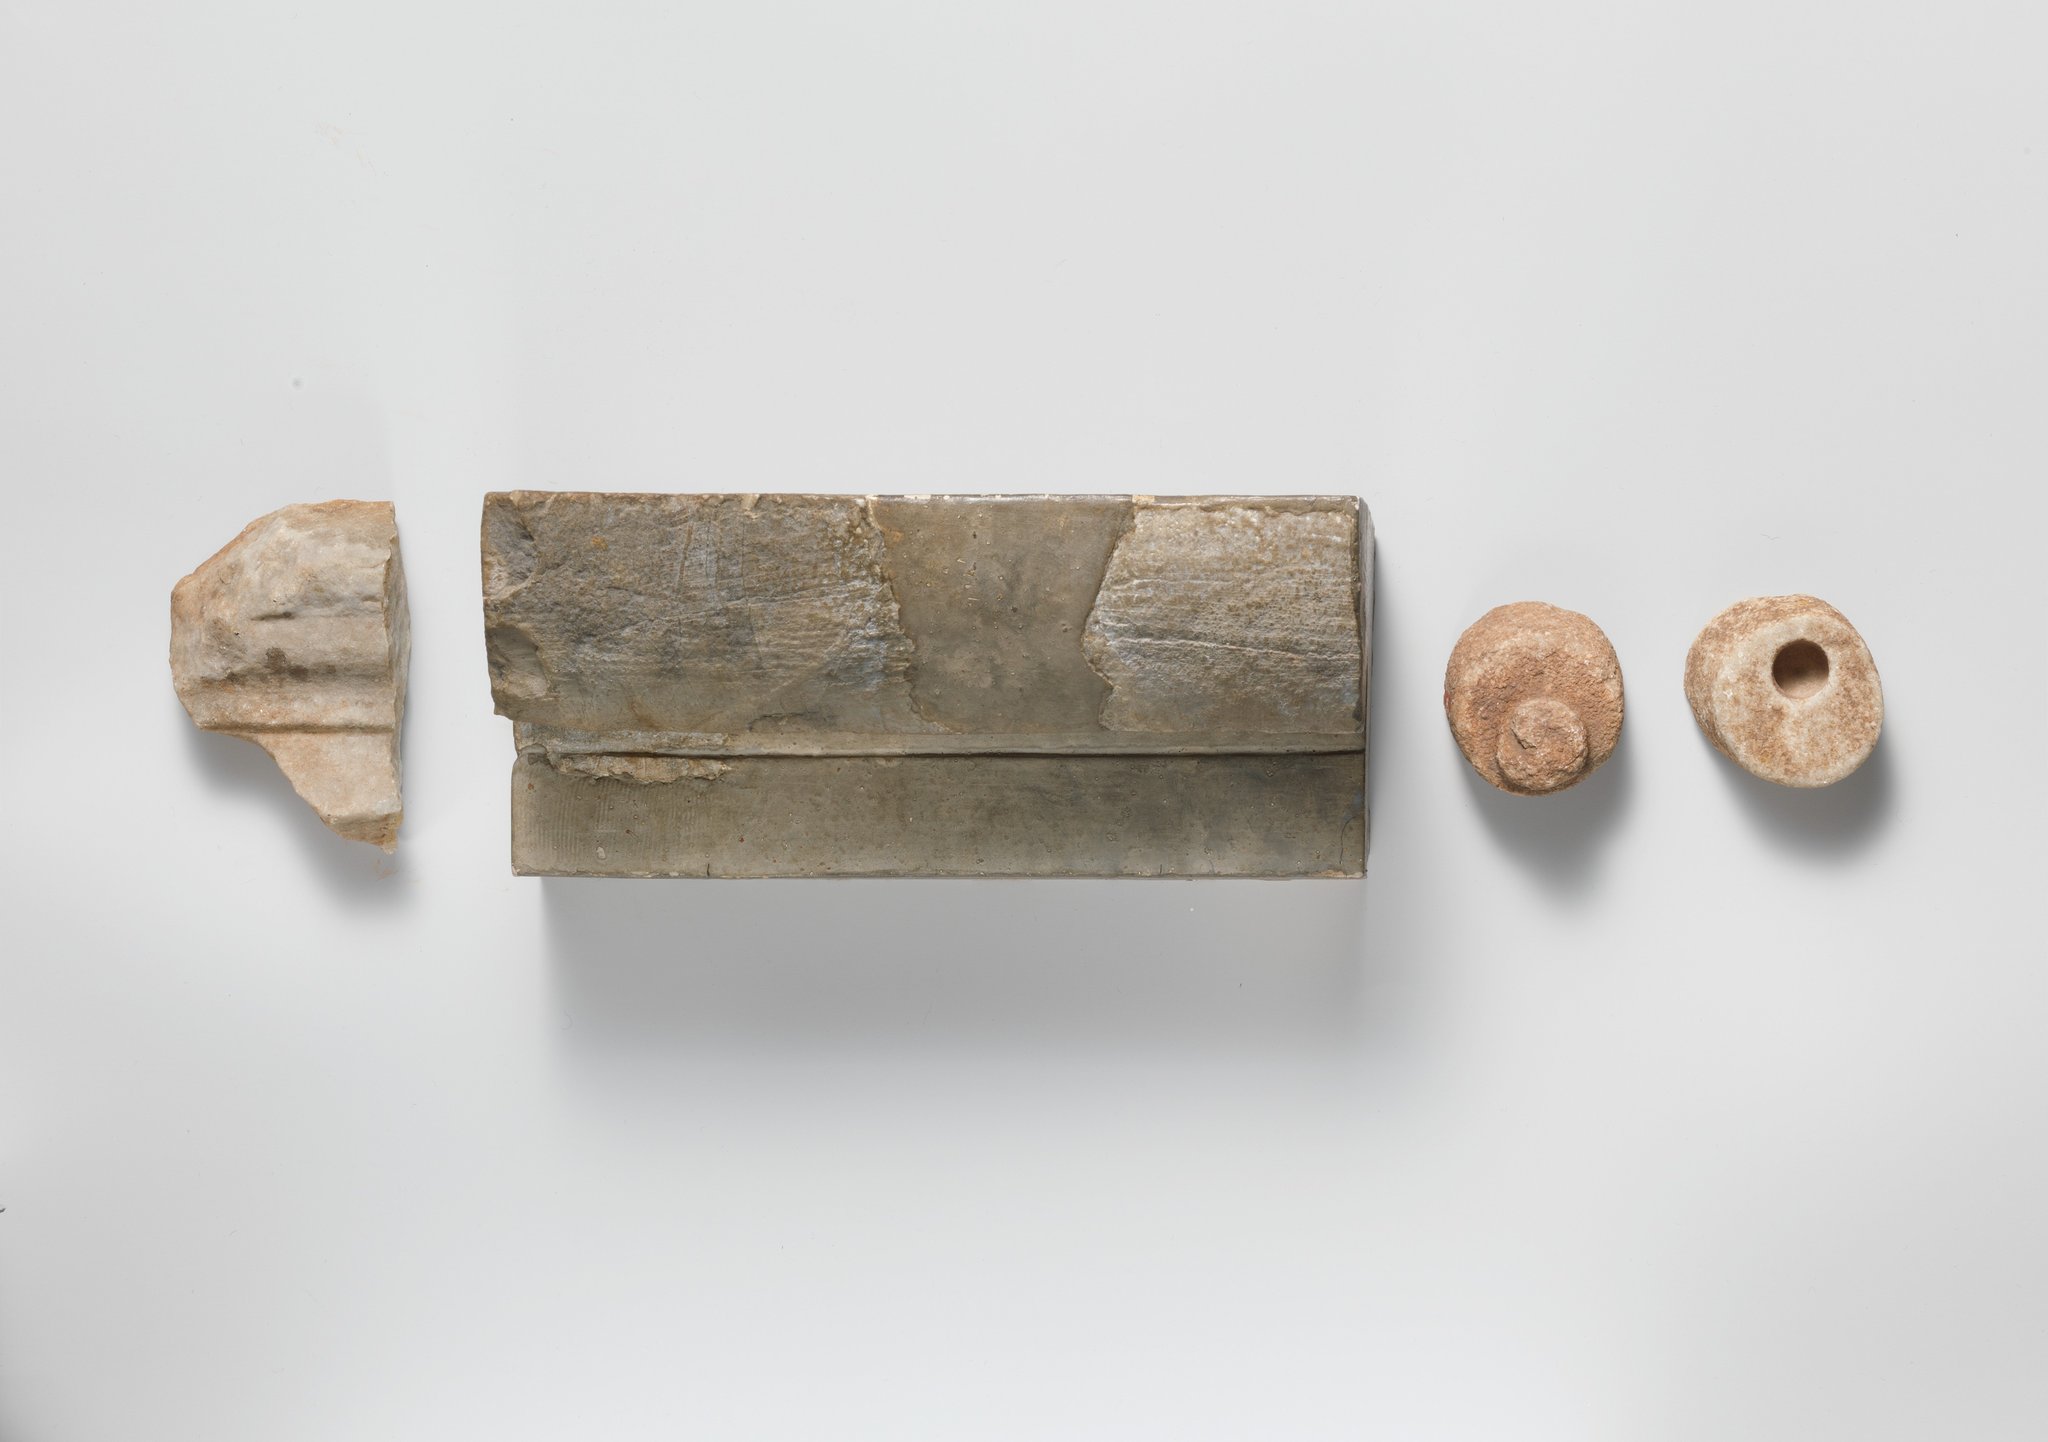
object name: architectural fragment bed molding of ceiling coffer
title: Bed molding of ceiling coffer from a group of fragments from the Temple of Apollo near Phigaleia (Bassae)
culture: greek, arcadian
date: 500-401 BCE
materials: marble